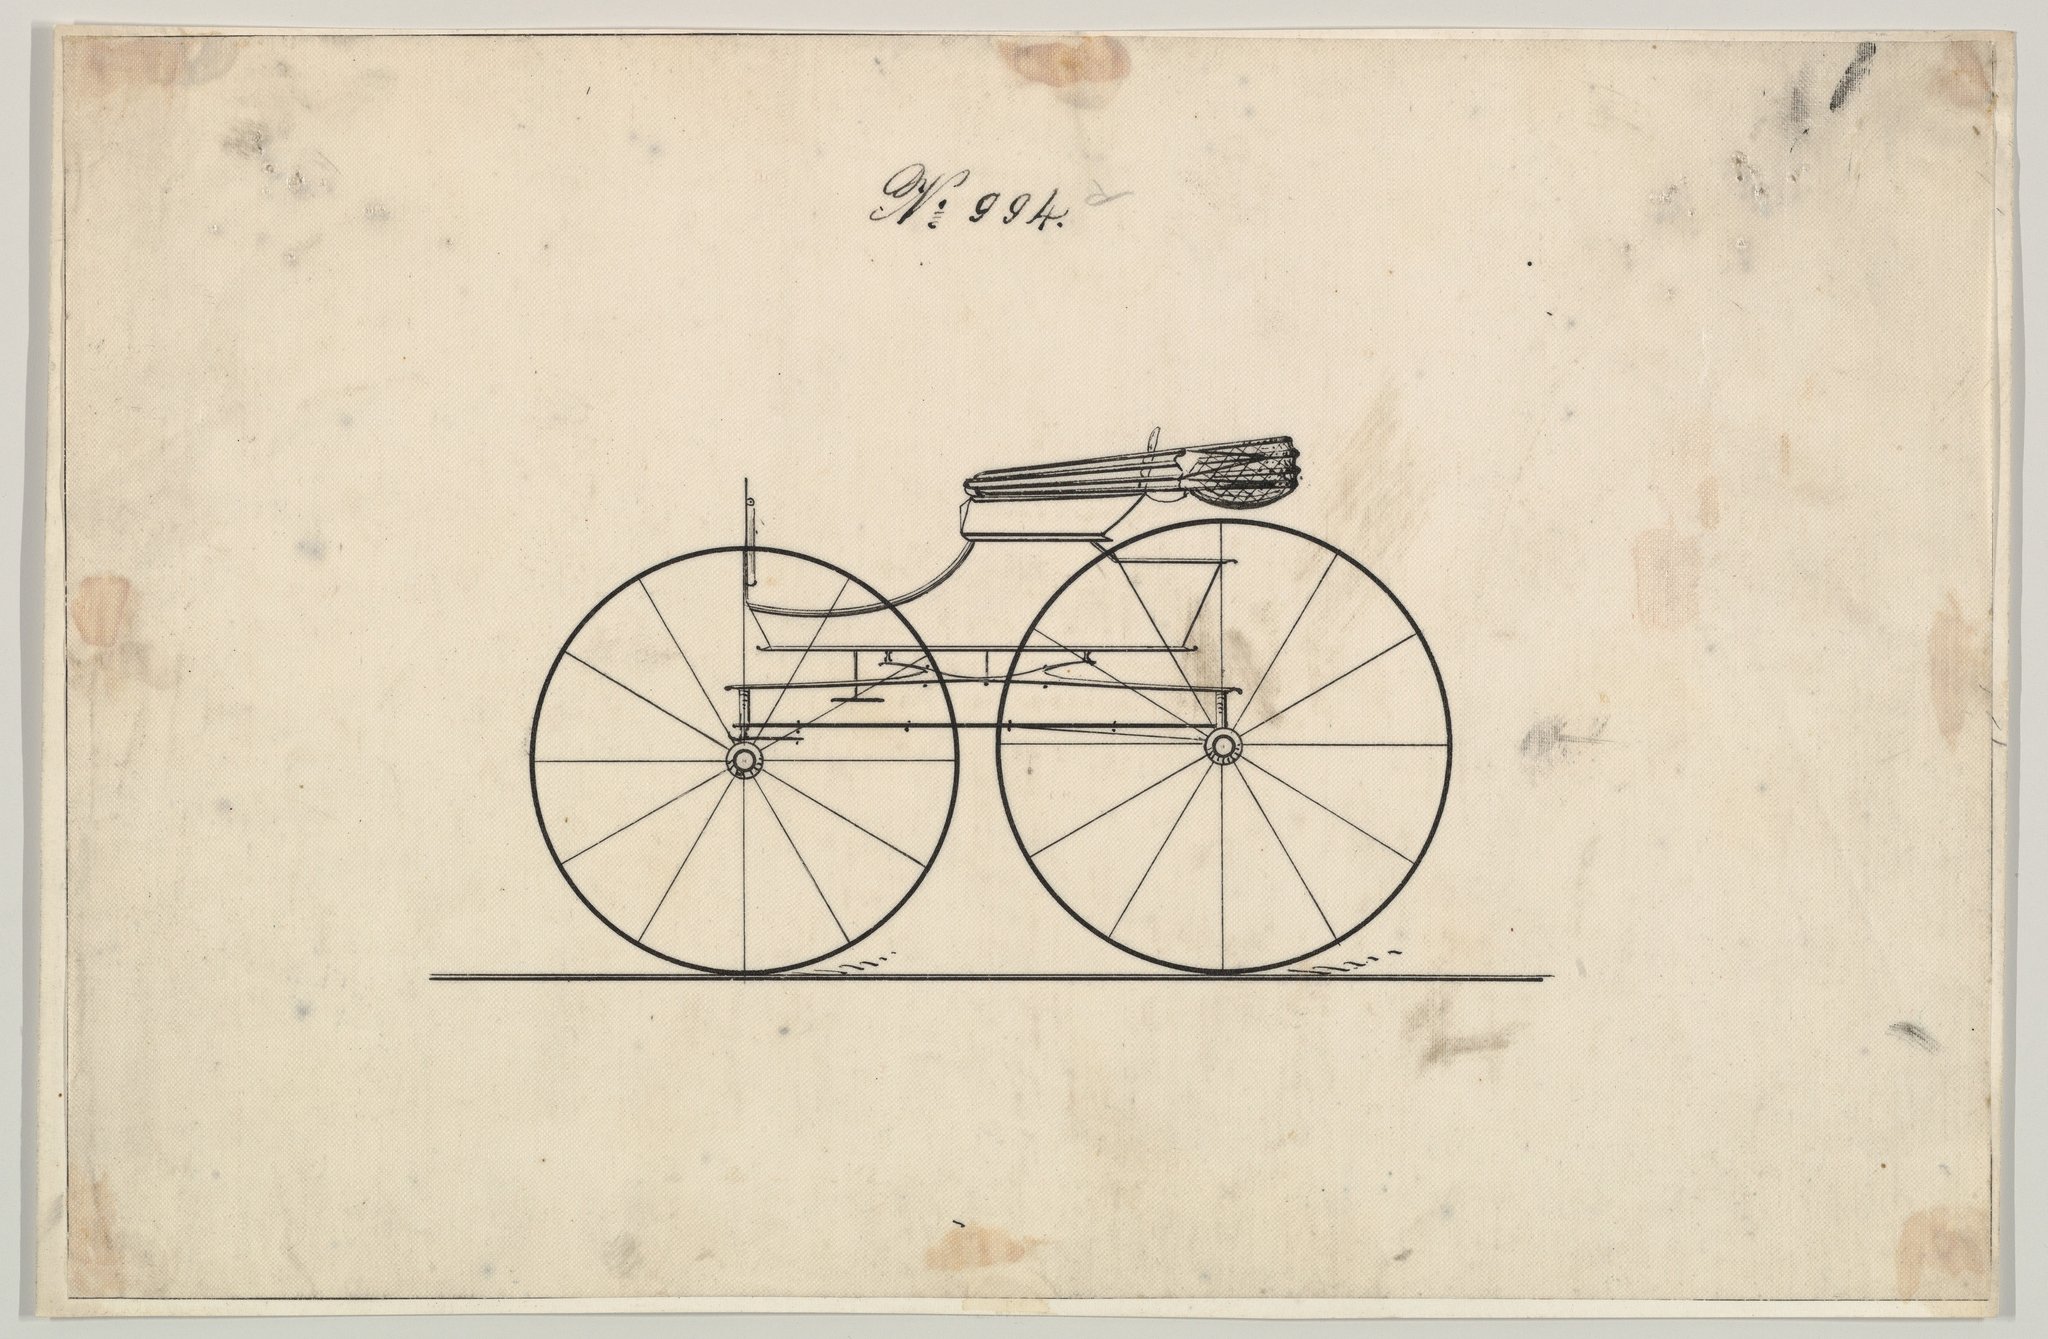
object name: drawing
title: Design for Wagon, no. 994d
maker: brewster & co.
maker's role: manufacturer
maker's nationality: american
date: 1870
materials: ink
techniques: pen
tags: carriages